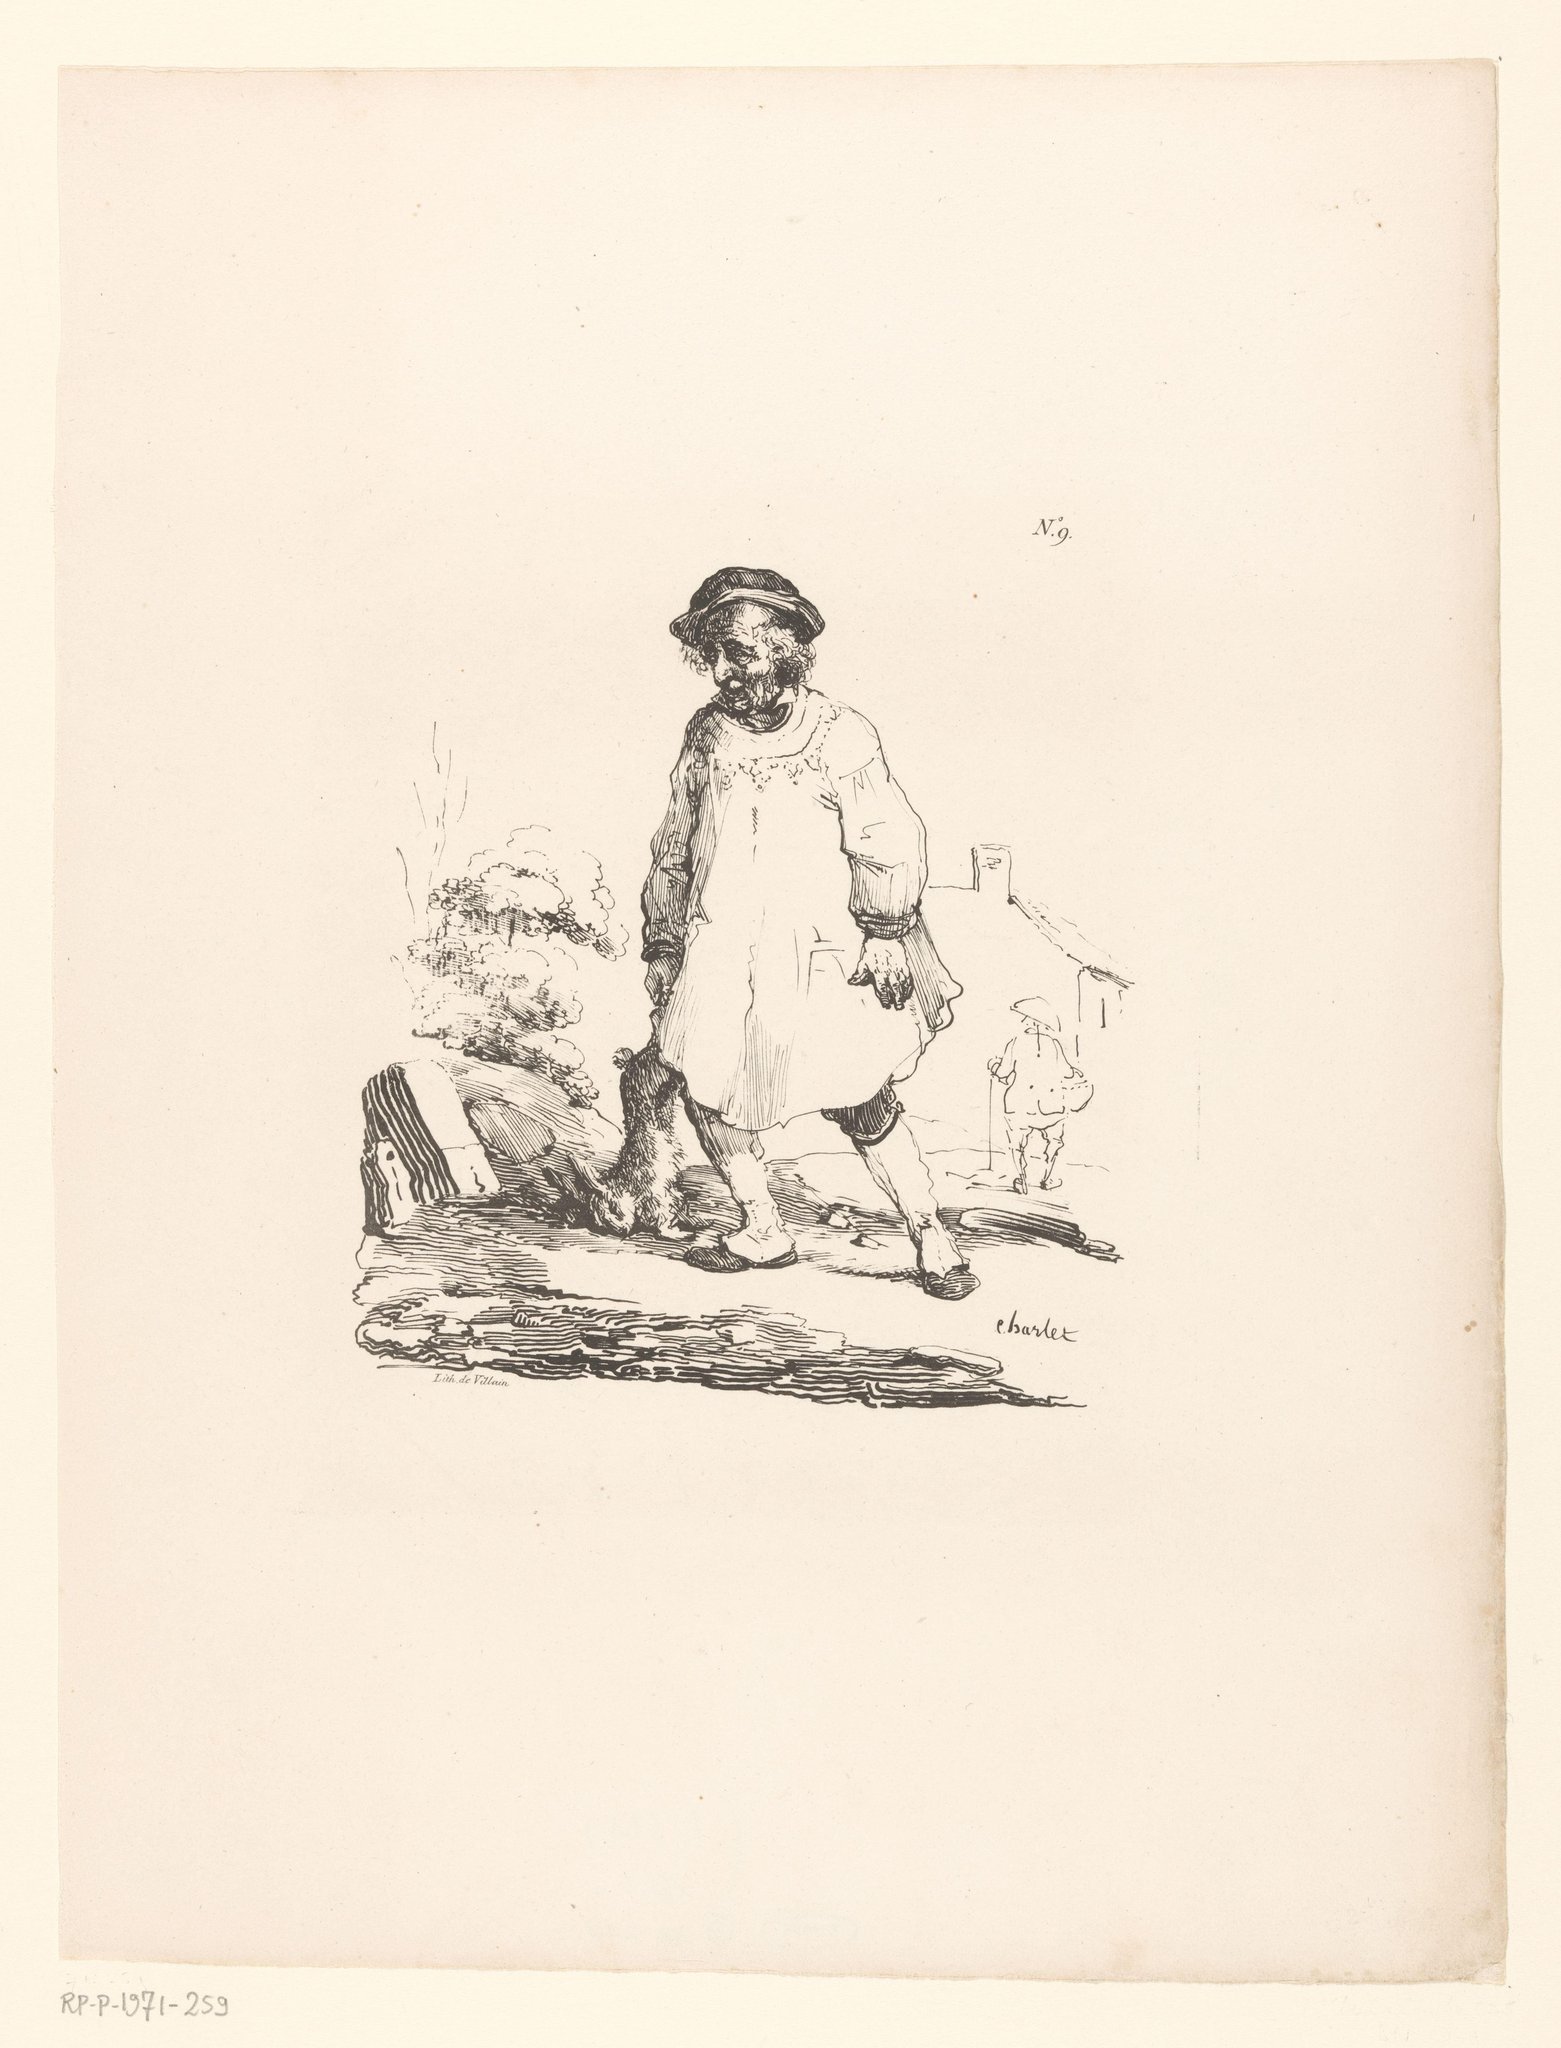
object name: print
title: Stroper met dode haas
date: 1823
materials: paper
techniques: lithograph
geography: paris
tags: poacher, rodents: hare, hare-hunting, rabbit-hunting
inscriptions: collector's mark: Lugt 2228a, collector's mark: Lugt 2760